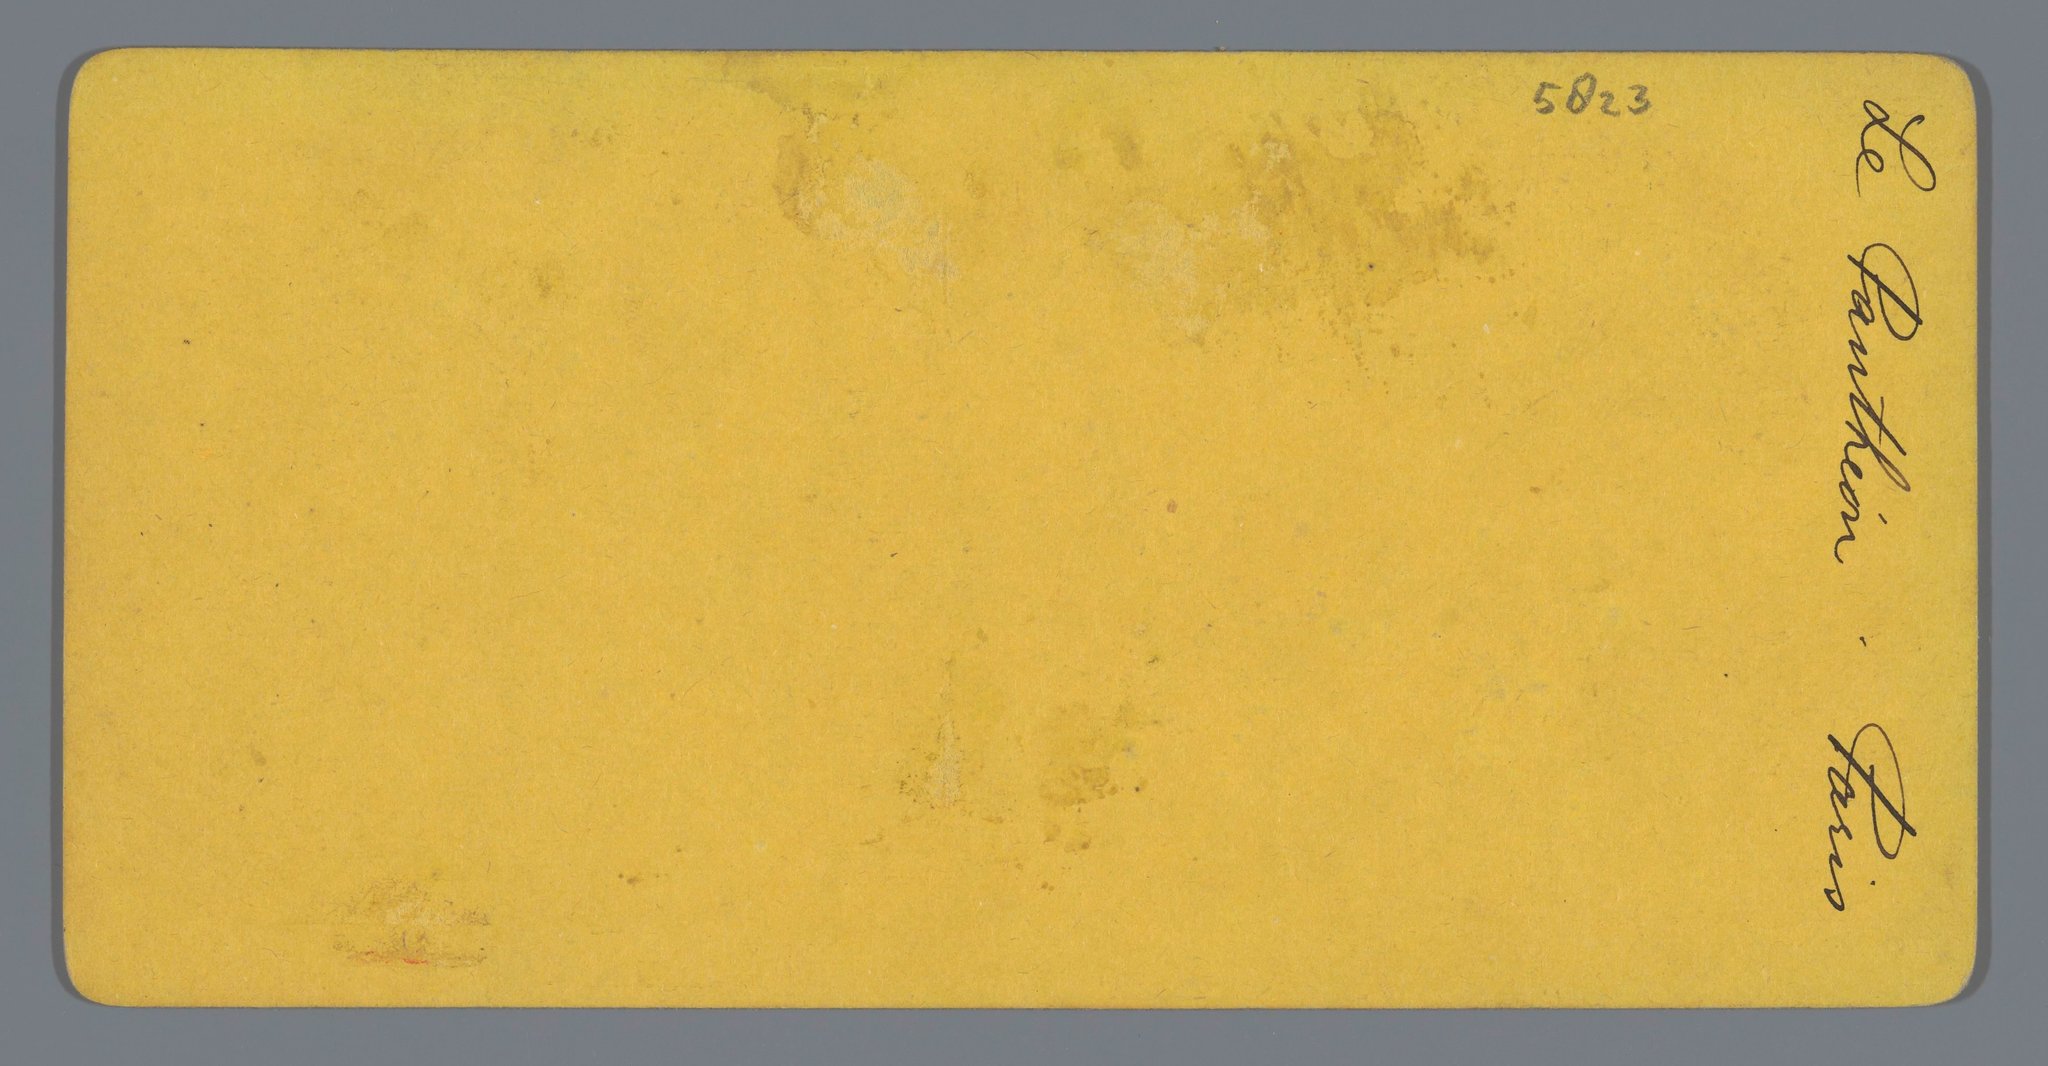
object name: stereograph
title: Gezicht op het Panthéon in Parijs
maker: Anonymous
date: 1850-1880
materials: cardboard, photographic support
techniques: albumen print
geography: paris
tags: dome ~ architecture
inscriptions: inscription: ‘Le Panthéon Paris’